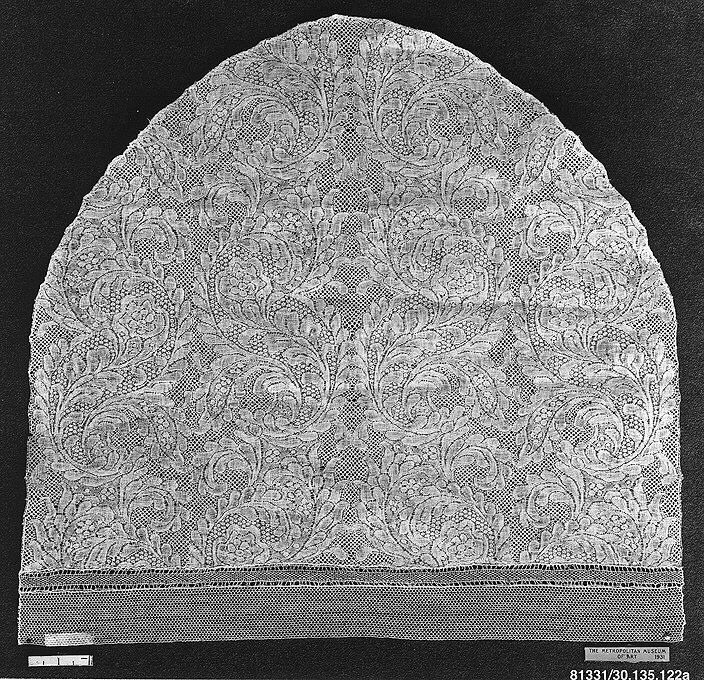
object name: cap crown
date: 1701-1800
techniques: lace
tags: flowers